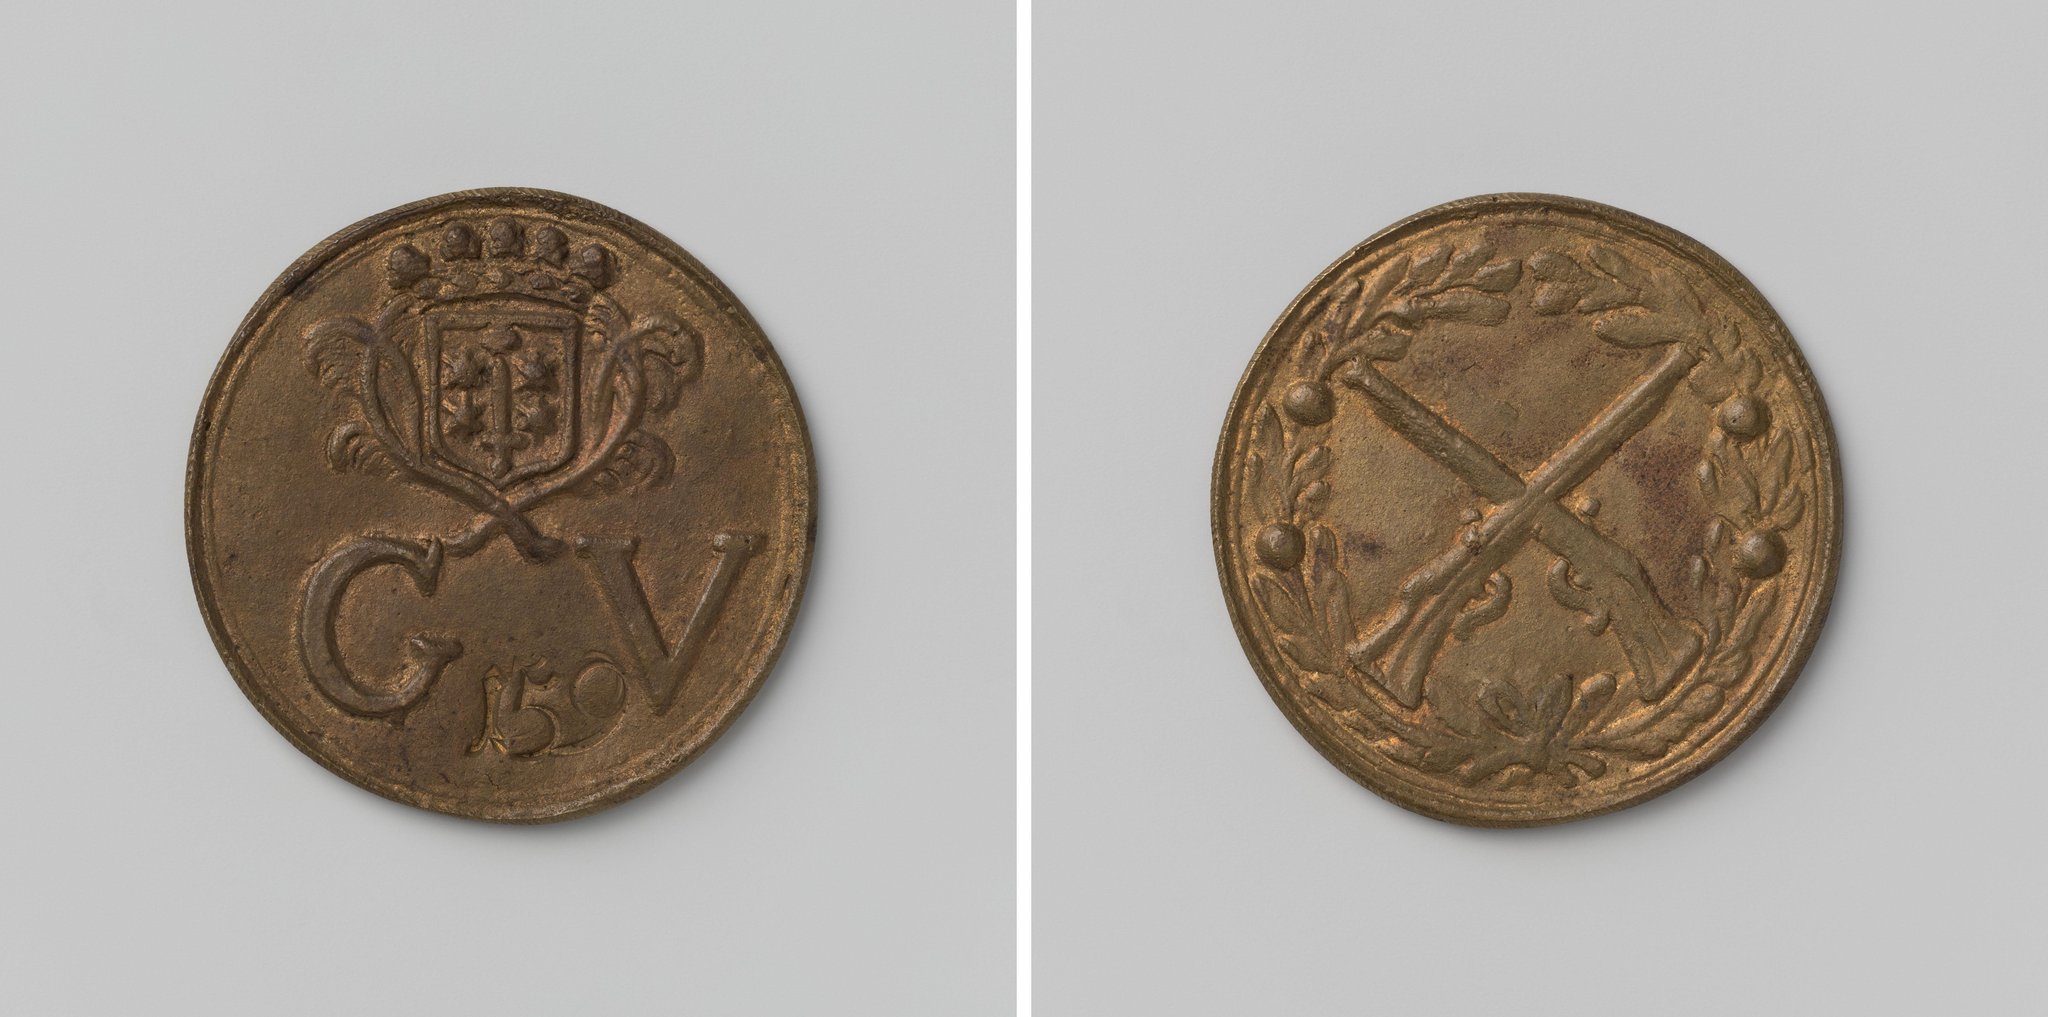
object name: marksman medal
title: Schutterij van Haarlem, schutterspenning van het Gele Vaandel met no. 46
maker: Anonymous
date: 1650-1750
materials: brass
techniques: casting, engraving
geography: haarlem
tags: haarlem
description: Messing penning met gat erin. Voorzijde: gekroond wapenschild op twee gekruiste palmtakken boven letters G en V; daartussen: cijfer 46. Keerzijde: twee gekruiste musketten binnen bladerkrans met vruchten